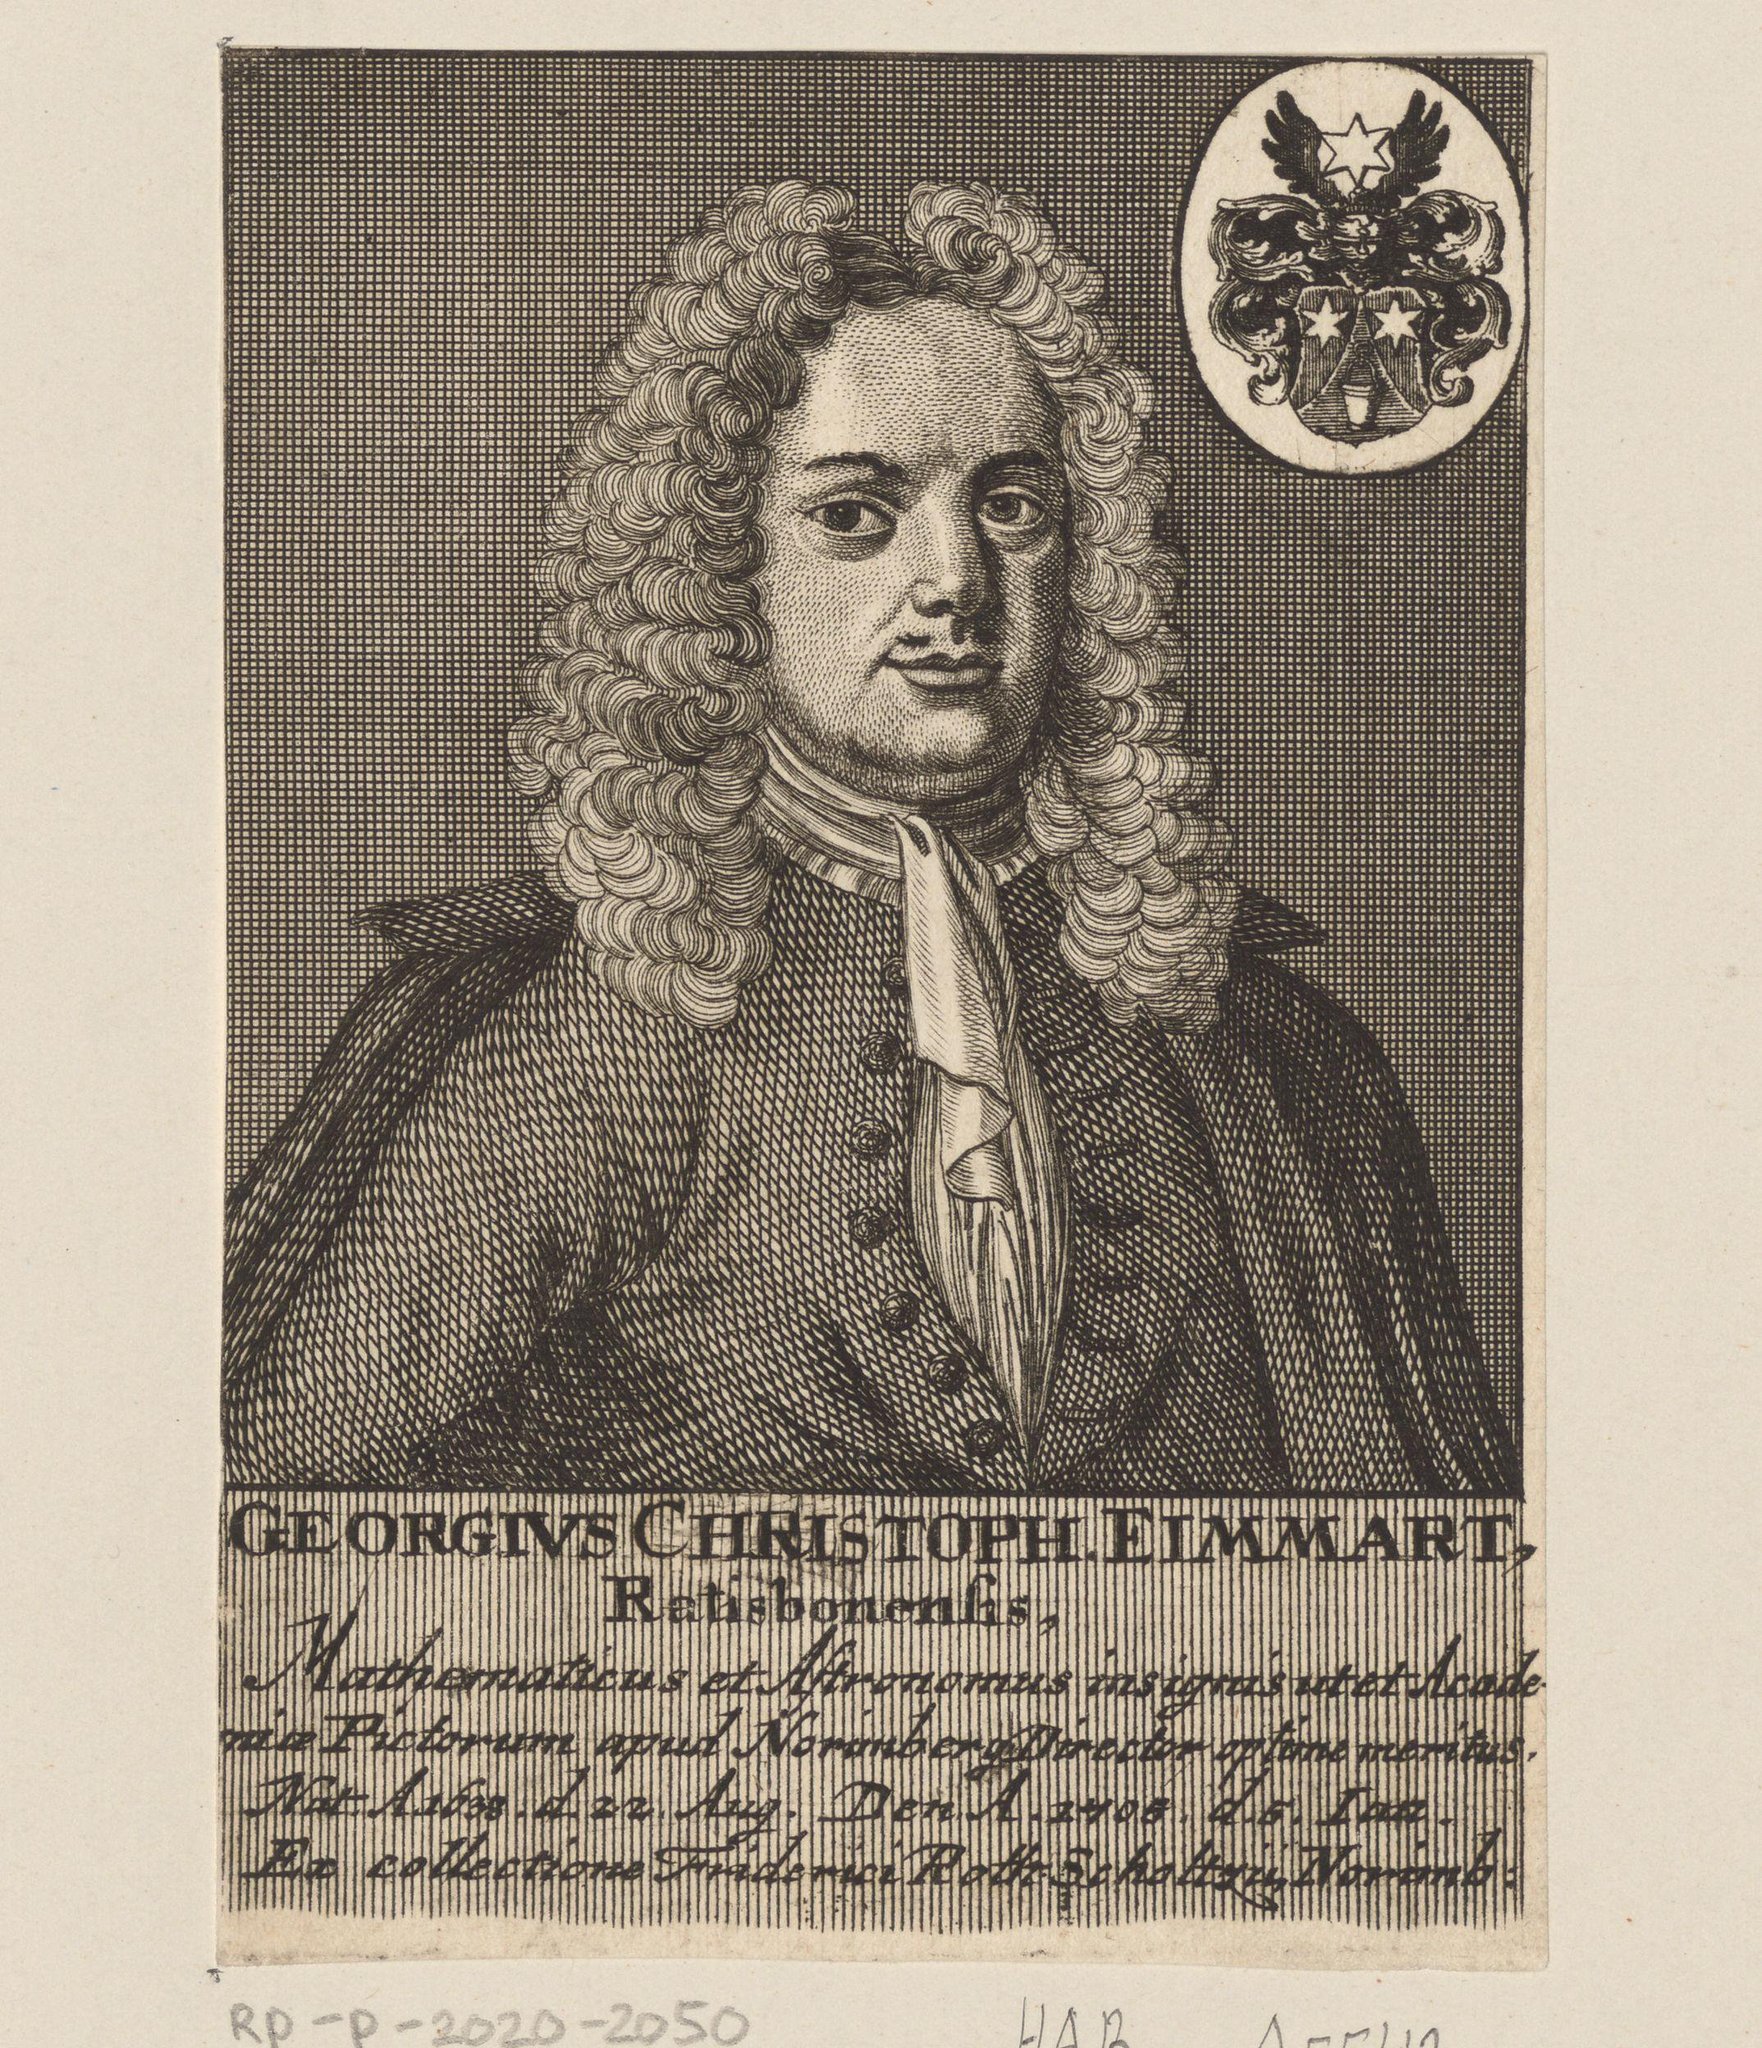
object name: print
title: Portret van Georg Christoph Eimmart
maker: Anonymous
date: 1720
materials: paper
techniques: engraving, etching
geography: germany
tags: print maker, georg christoph eimmart (ii), historical persons, portrait, self-portrait of graphic artist, armorial bearing, heraldry